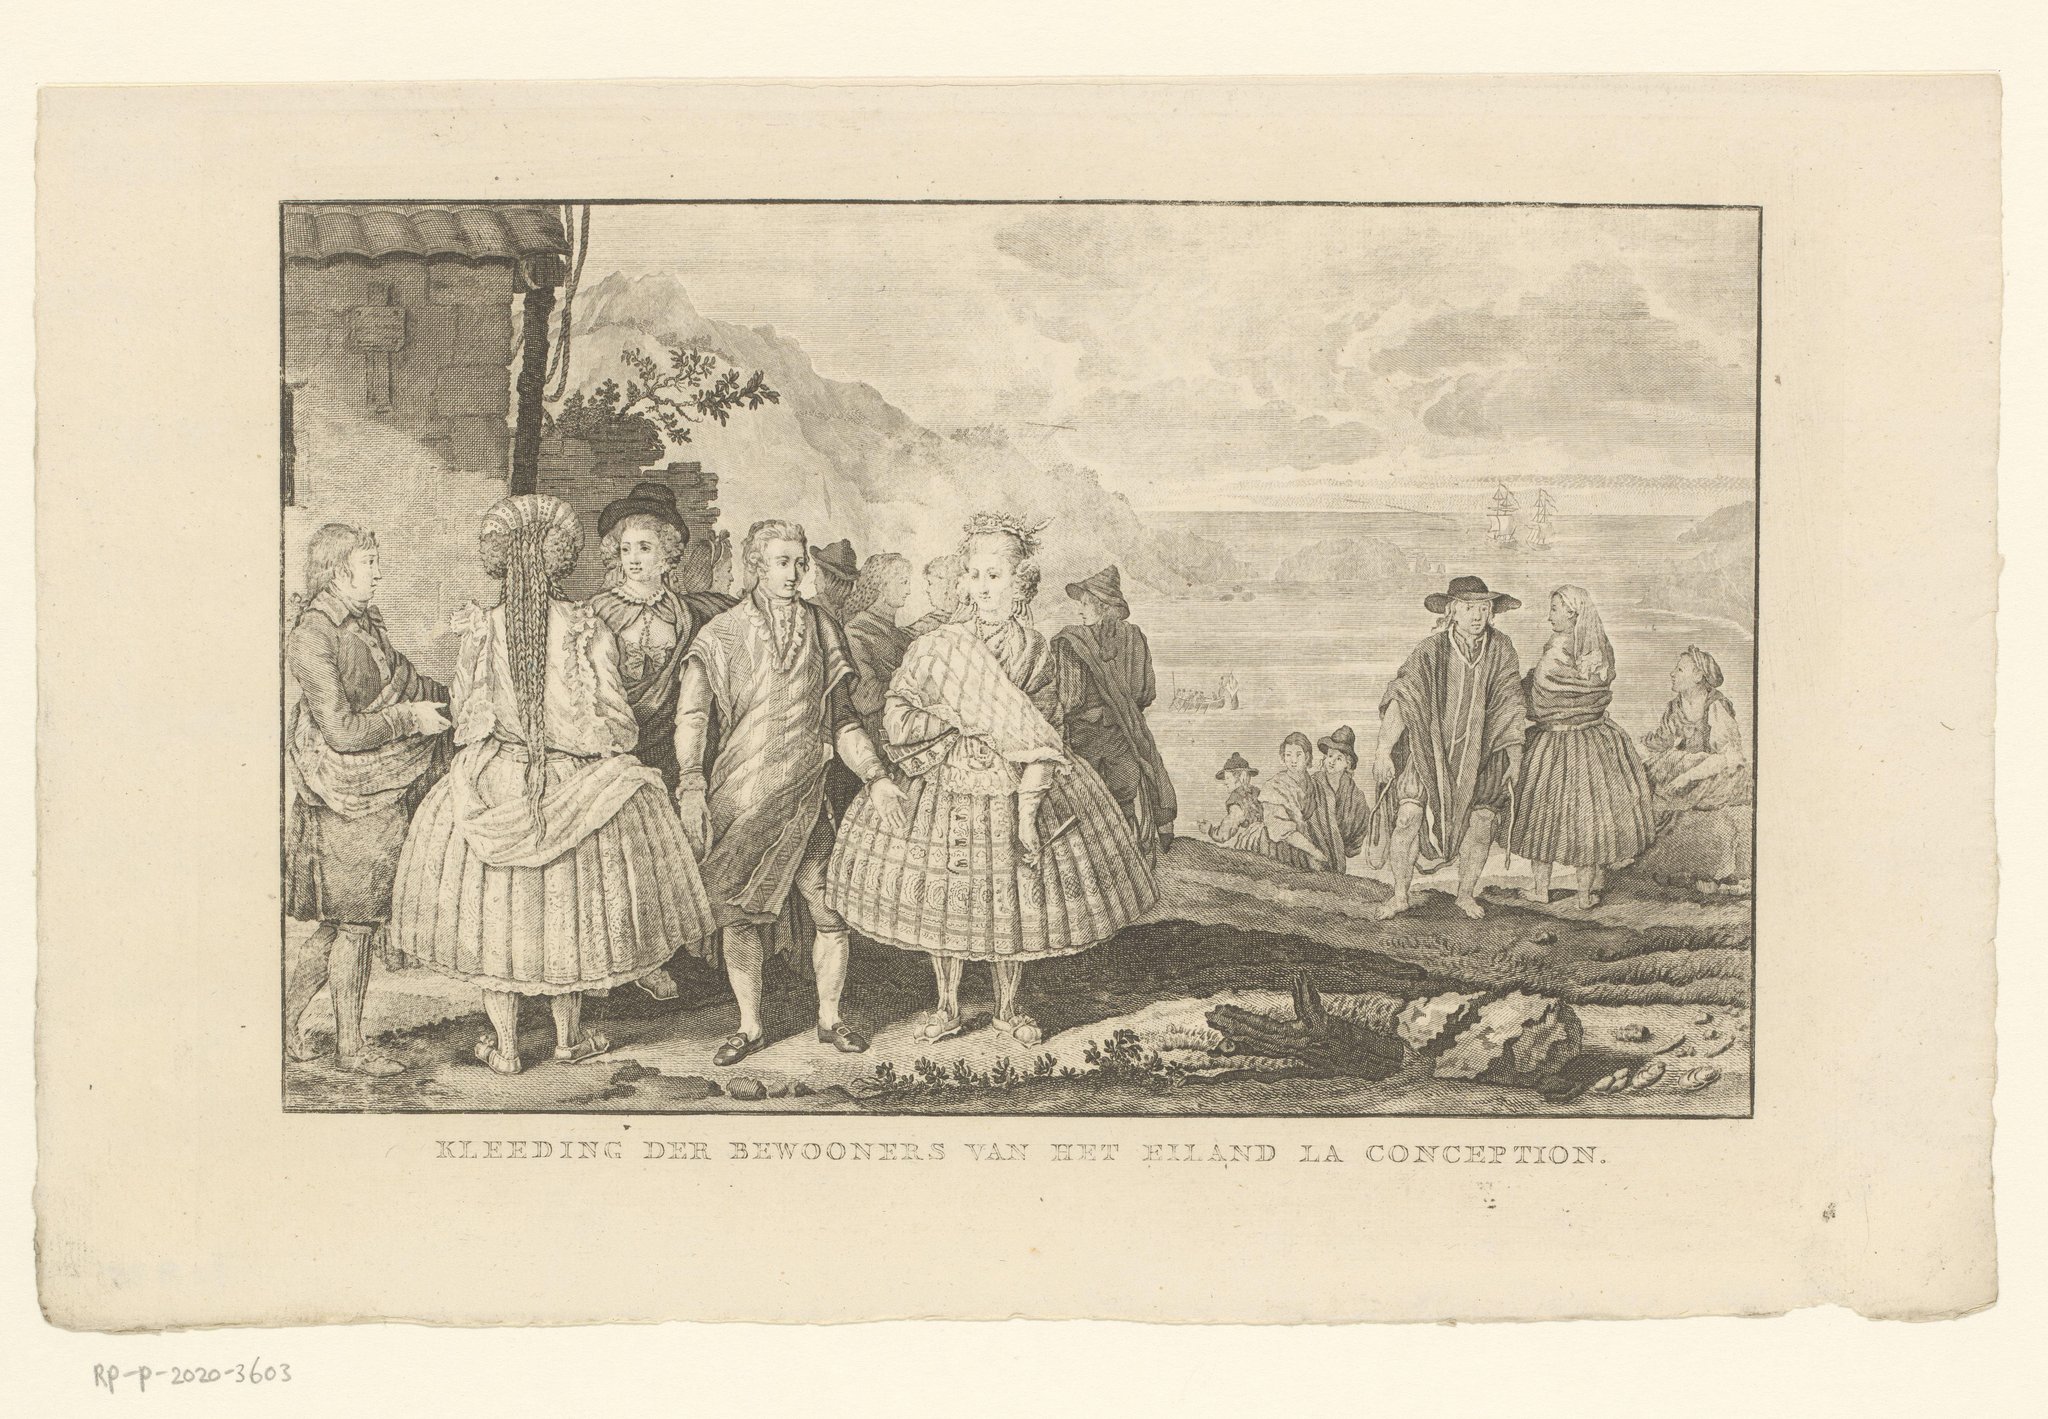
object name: book illustration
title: Kleeding der bewooners van het eiland La Conception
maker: Anonymous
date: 1801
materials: paper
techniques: etching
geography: amsterdam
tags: gulf, bay, island, folk costume, regional costume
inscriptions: collector's mark: Lugt 2228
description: Prent waarschijnlijk uit: La Pérouse, Jean-François de. Reize van de La Pérouse, in de jaaren 1785, 1786, 1787, en 1788. Amsterdam: Johannes Allart, 1801, dl. 1.